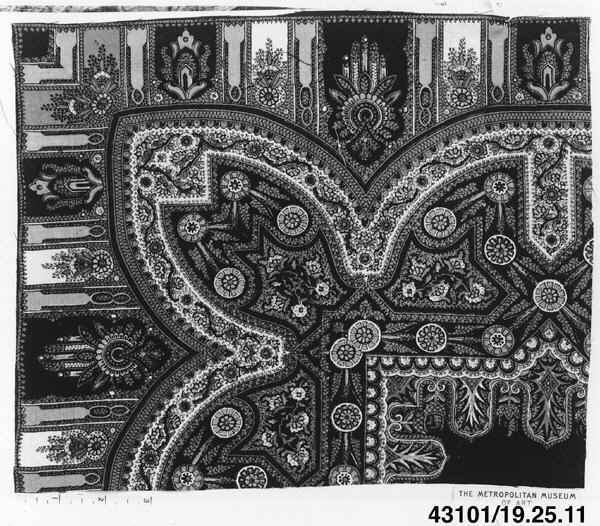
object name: sample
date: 1830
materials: wool